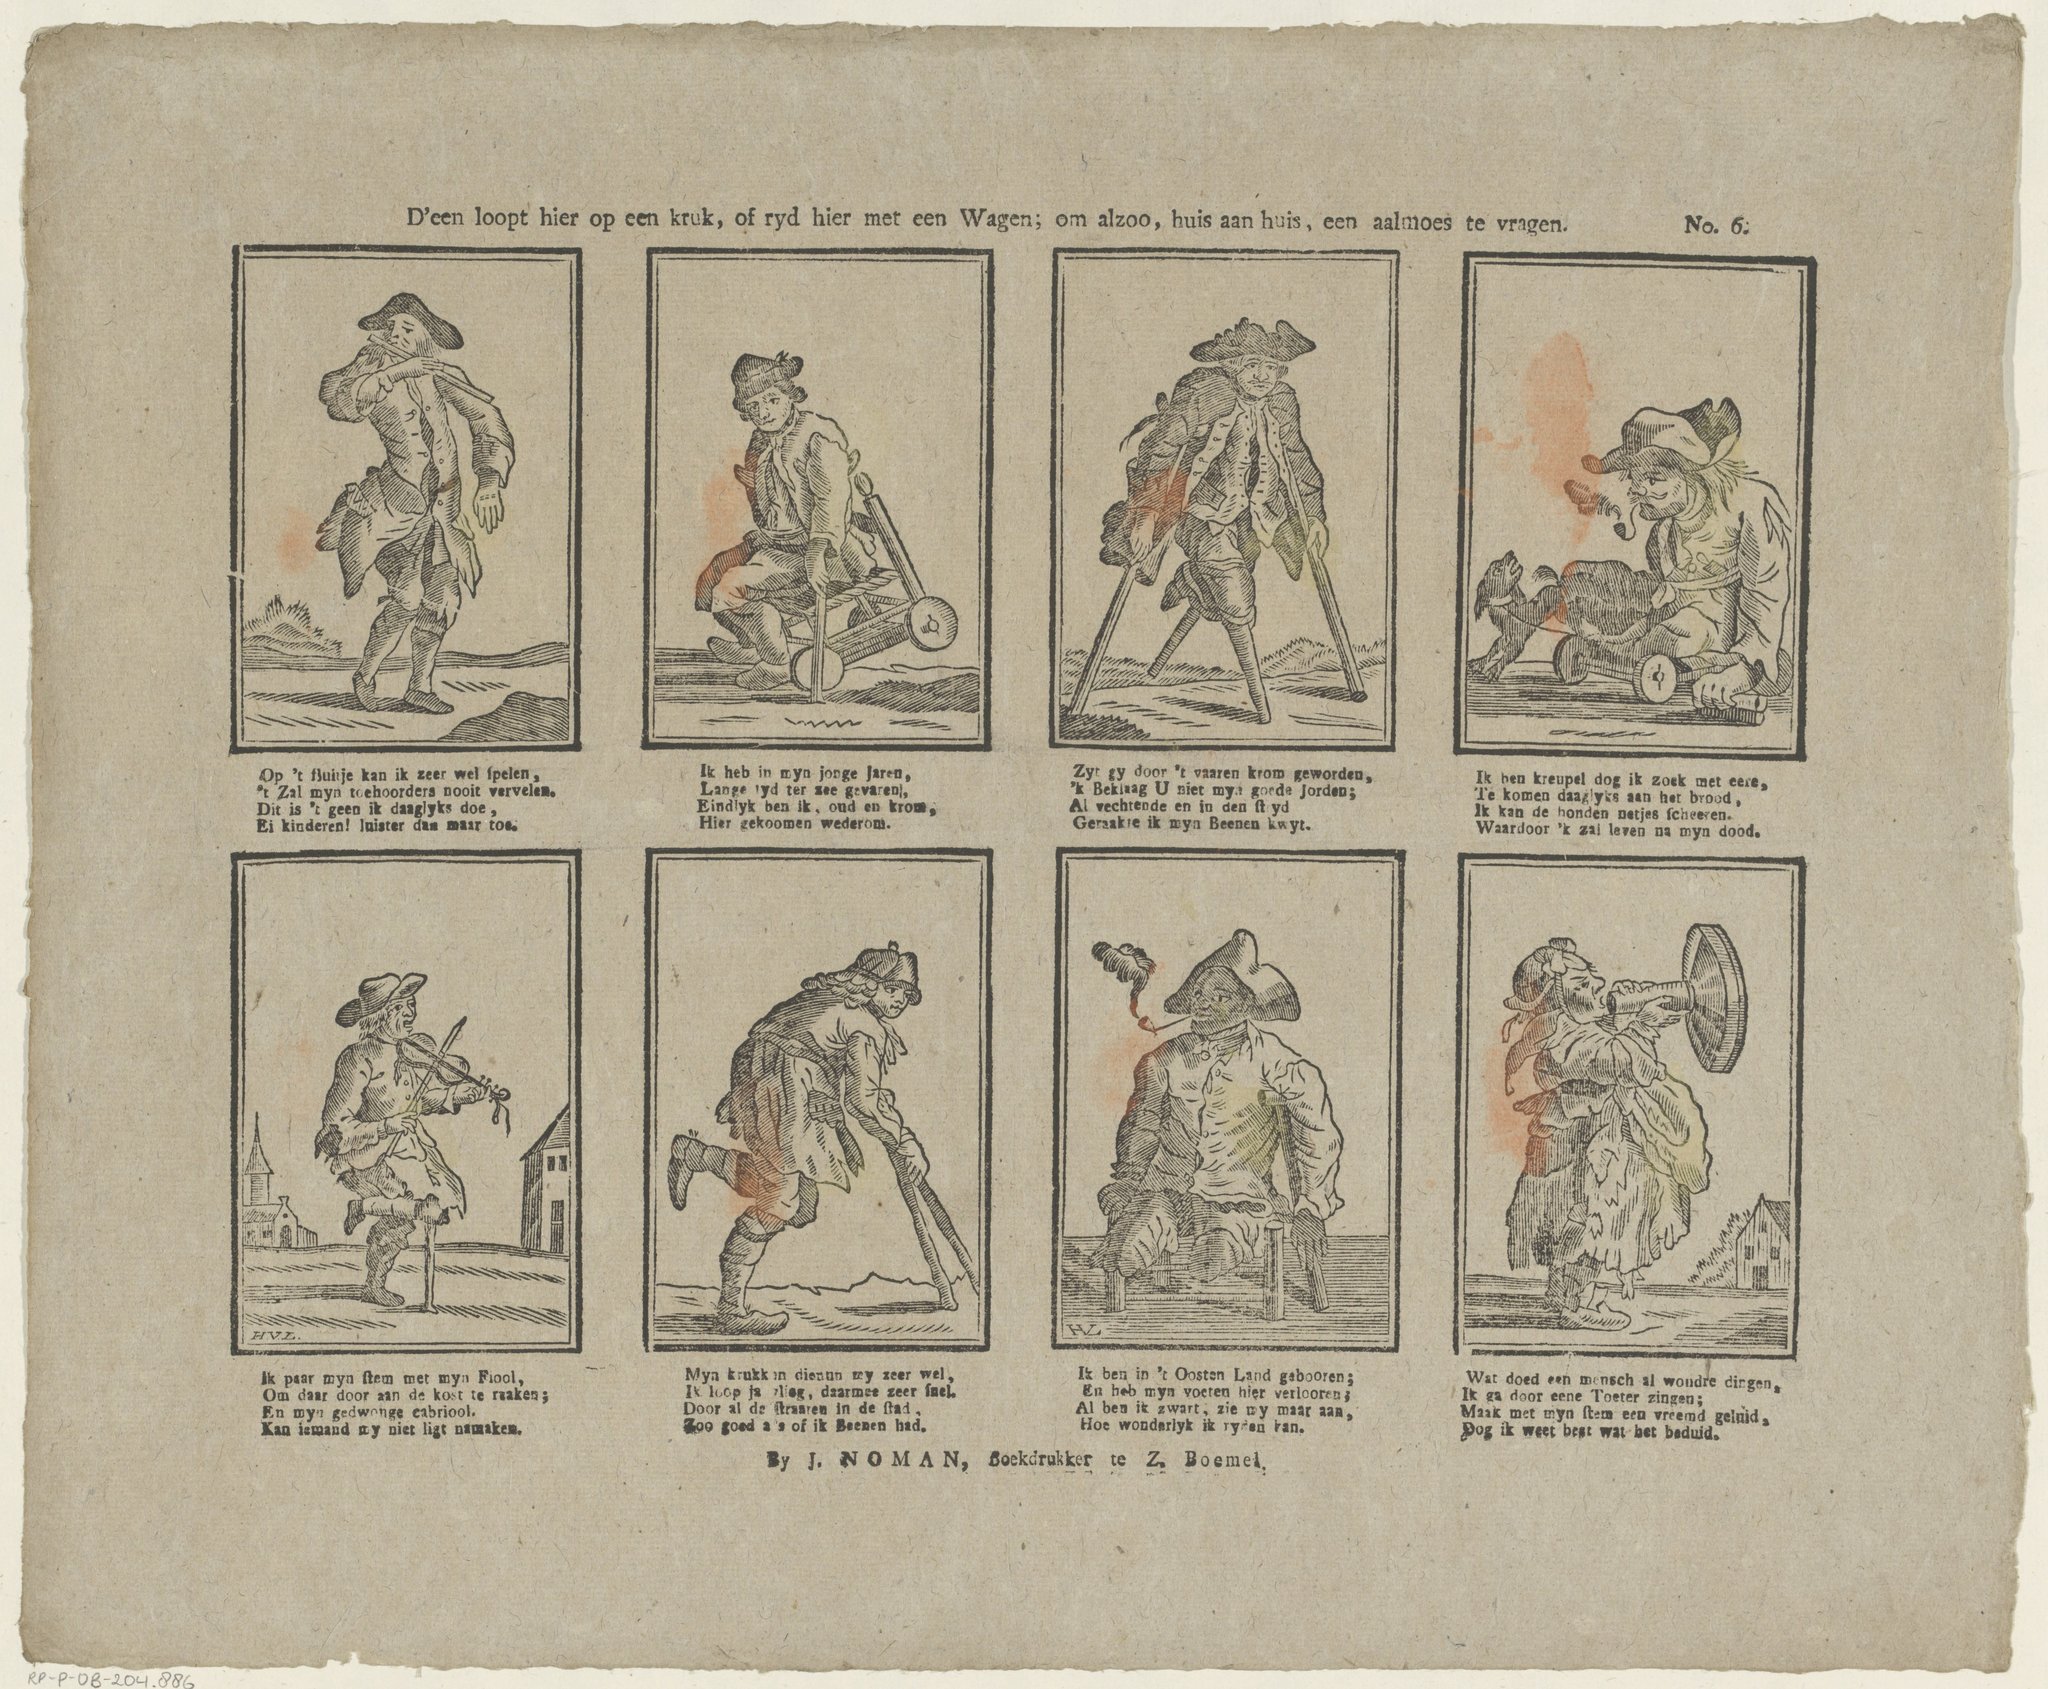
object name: popular print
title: D'een loopt hier op een kruk, of ryd hier met een wagen; om alzoo, huis aan huis, een aalmoes te vragen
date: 1806-1830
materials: paper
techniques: colour, letterpress printing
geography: netherlands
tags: person with a physical disability, beggar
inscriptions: collector's mark: Lugt 2760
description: Blad met 8 voorstellingen van bedelaars met diverse lichamelijke beperkingen. In rijm worden hun dagelijkse bezigheden beschreven. Onder elke afbeelding een vierregelig vers. Genummerd rechtsboven: No. 6.